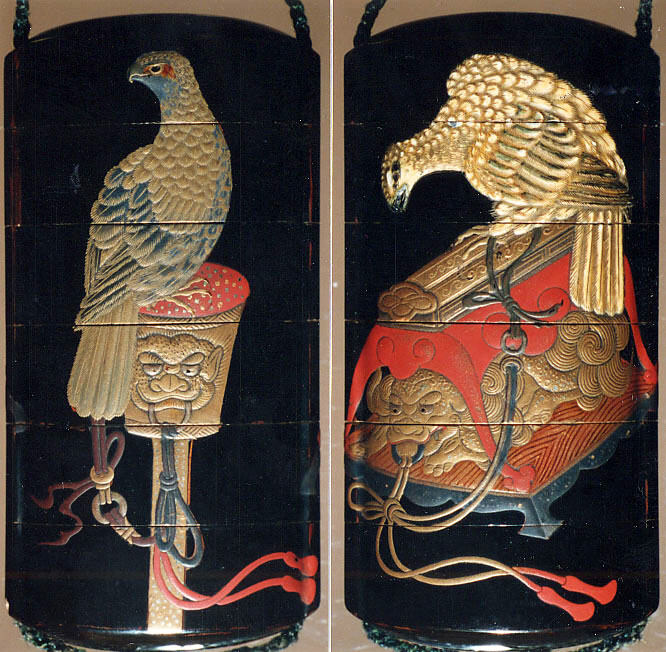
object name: inrō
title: Case (Inrō) with Design of Hawks on Tasseled Perches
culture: japanese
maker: kano terunobu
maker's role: artist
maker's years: 1717-1763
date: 1801-1900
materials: gold, lacquer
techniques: fundame, hiramakie, roiro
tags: hawks